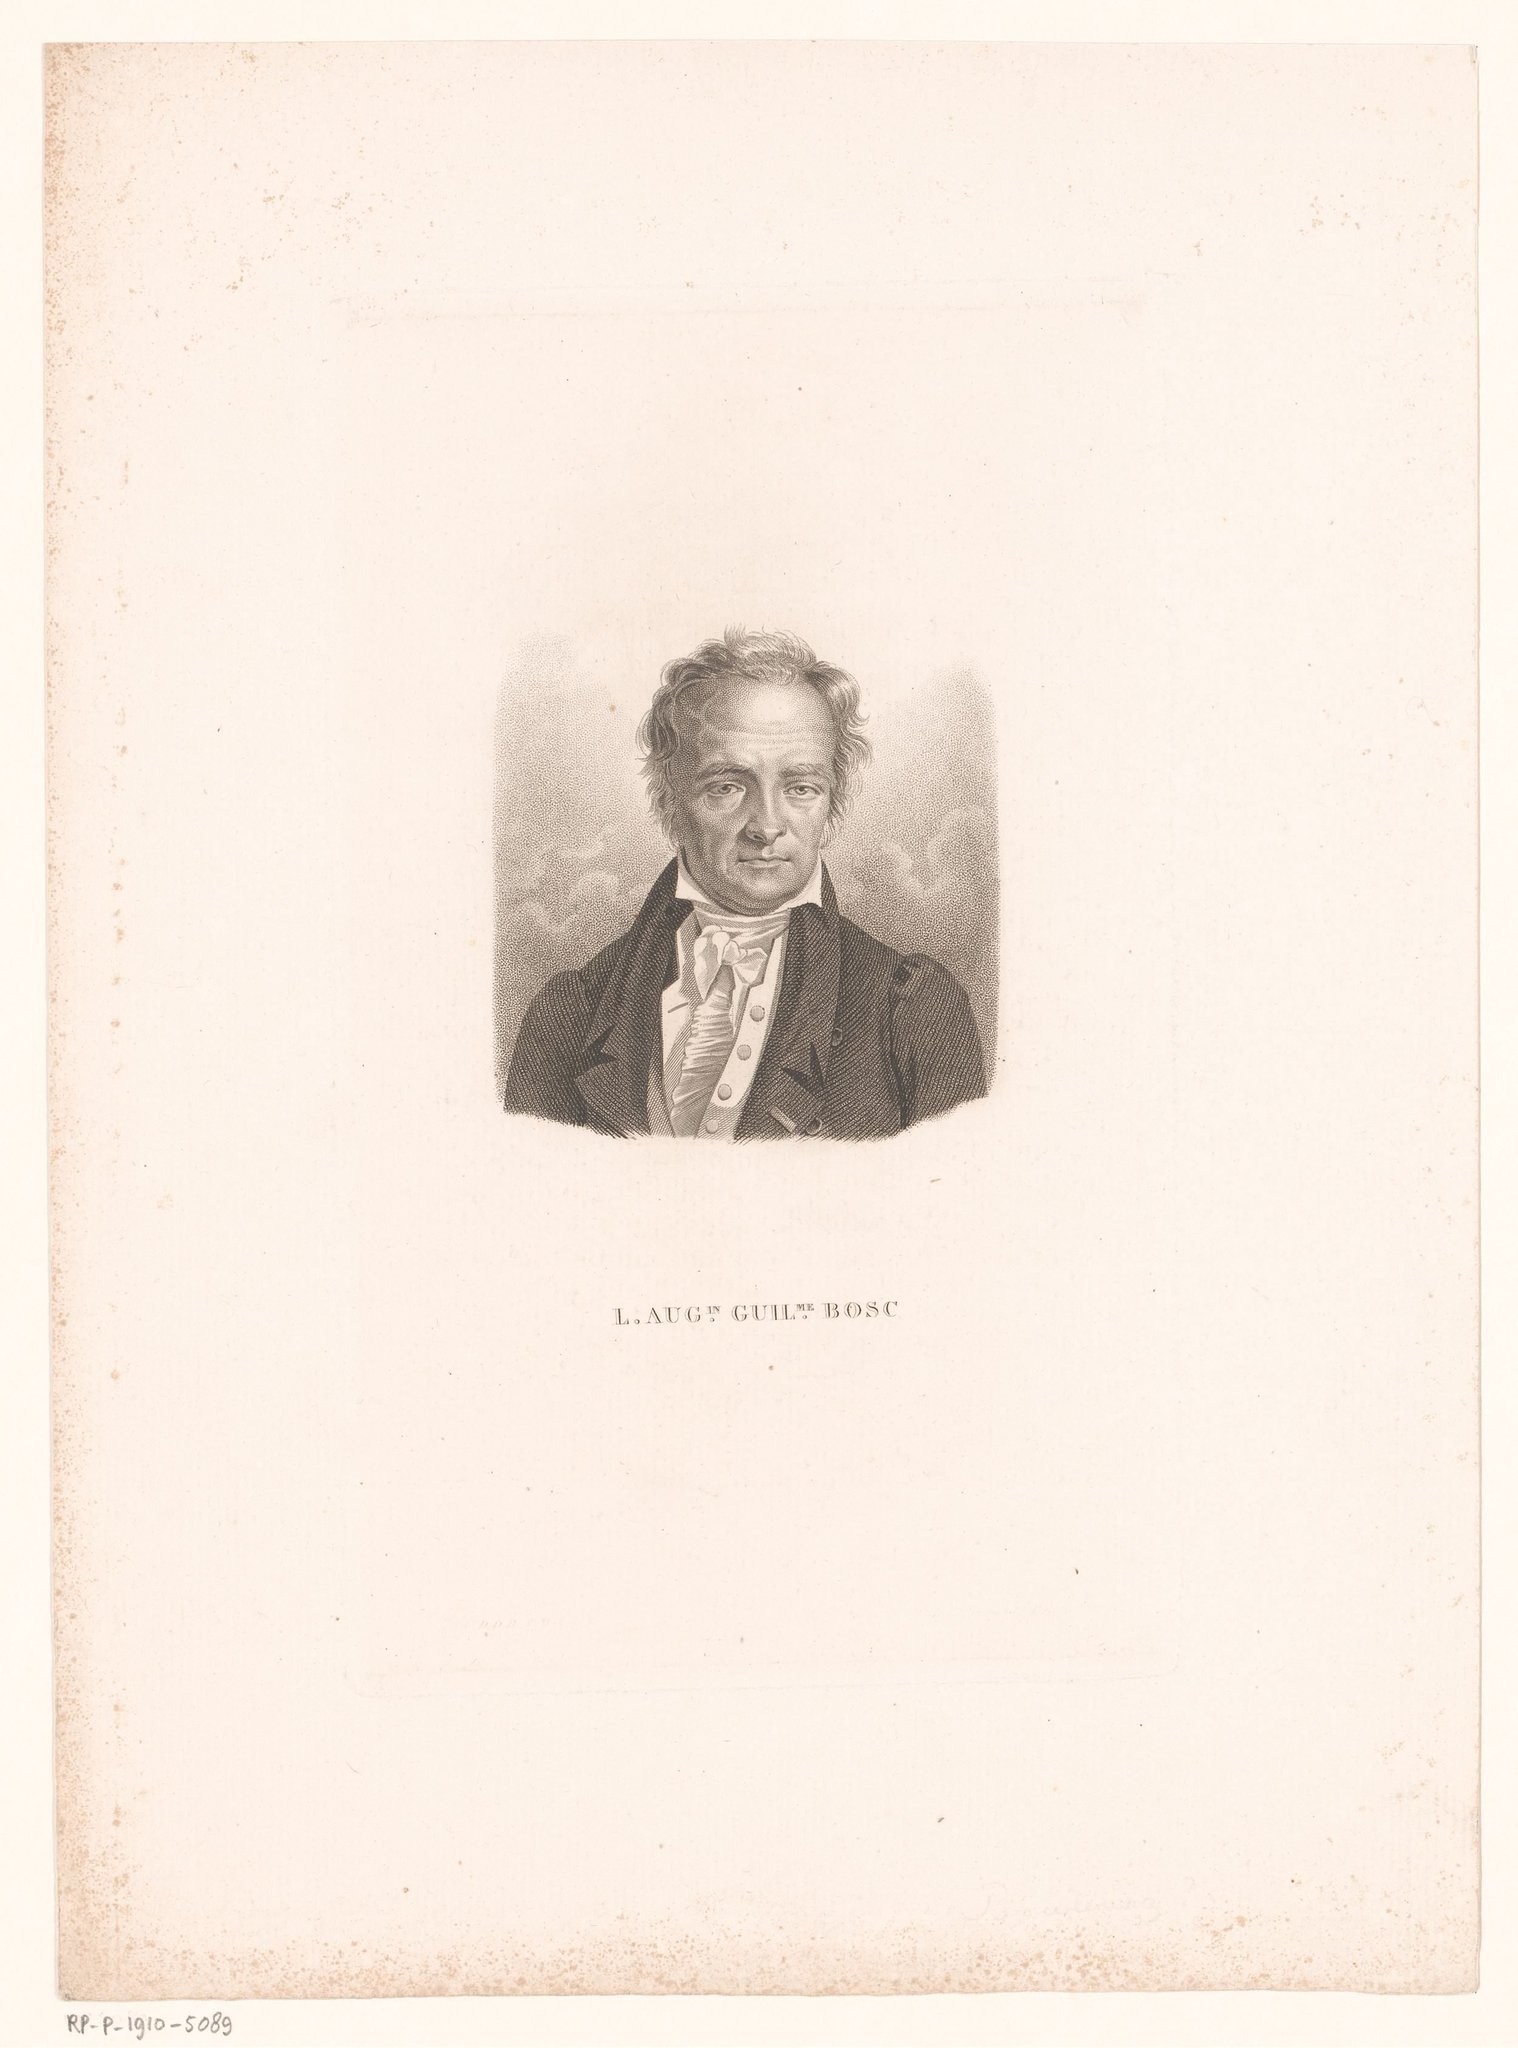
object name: book illustration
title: Portret van Louis-Augustin Bosc d'Antic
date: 1818-1832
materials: paper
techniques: engraving, roulette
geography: france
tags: scholar, philosopher, historical persons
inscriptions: collector's mark: Lugt 2228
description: Mogelijk prent uit: Journal complémentaire du Dictionnaire des sciences médicales. Parijs: Panckoucke, Charles Louis Fleury, 1818-1832.